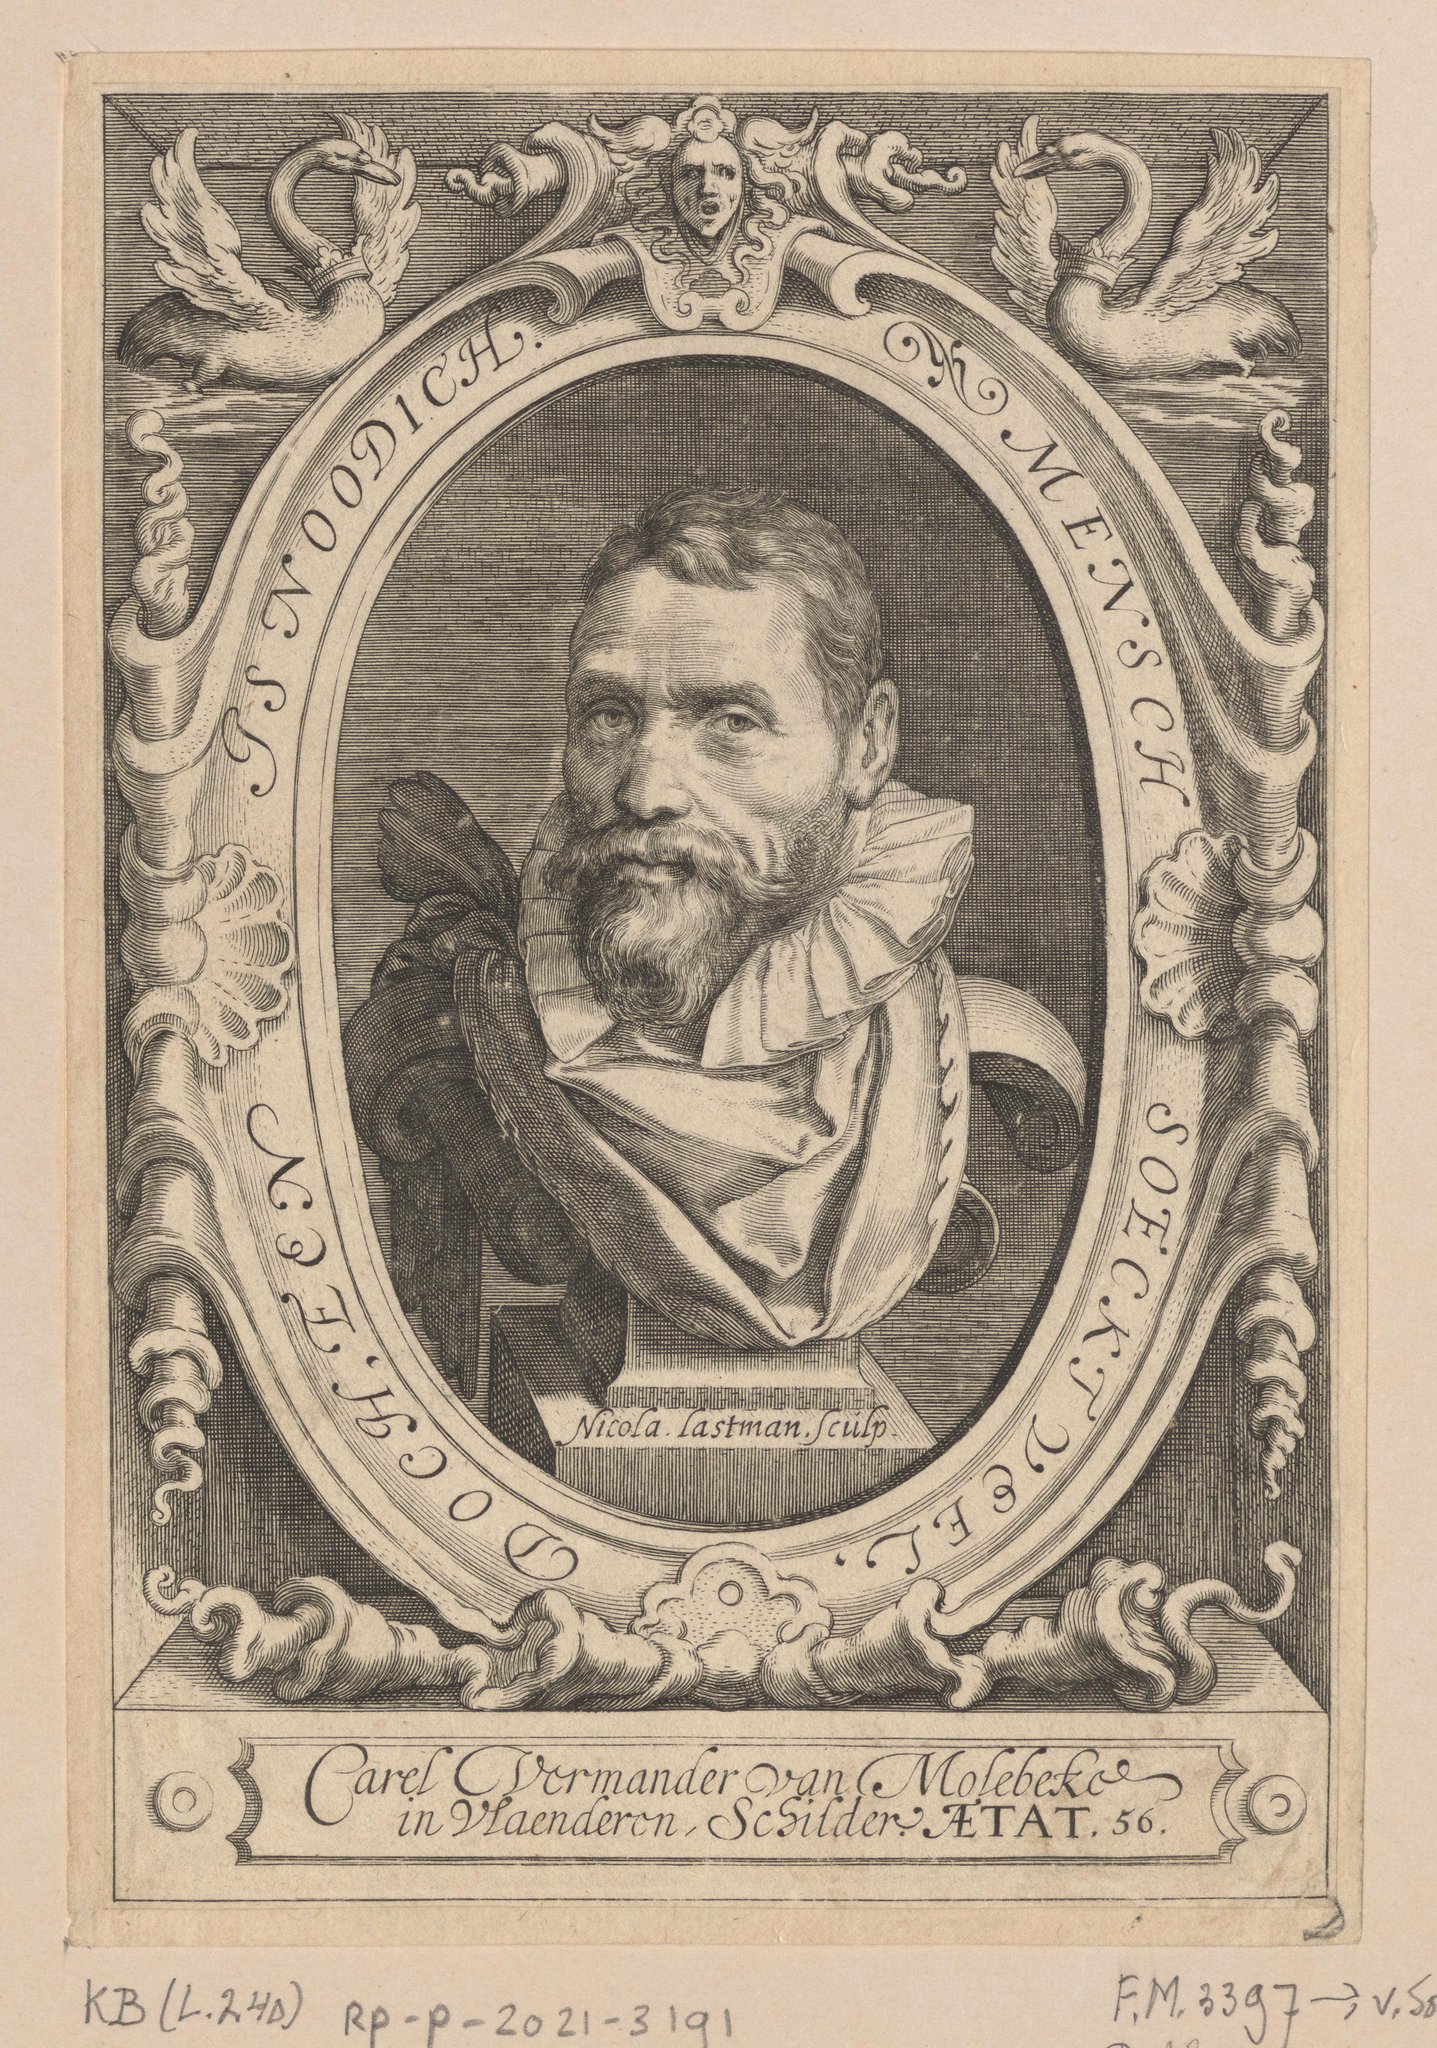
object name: book illustration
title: Portret van Karel van Mander op 56-jarige leeftijd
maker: nicolaes lastman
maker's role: print maker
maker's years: 1586-1625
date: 1618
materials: paper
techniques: engraving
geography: northern netherlands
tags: amsterdam, painter, print maker, draughtsman, karel van mander (i), water-birds: swan, ornament ~ medallion, historical persons, portrait of a writer, portrait, self-portrait of painter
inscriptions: collector's mark: Lugt 240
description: Met rondom het portret het motto 'Mensch soeckt veel, doch een is noodich', en onder het portret twee regels in het Nederlands.